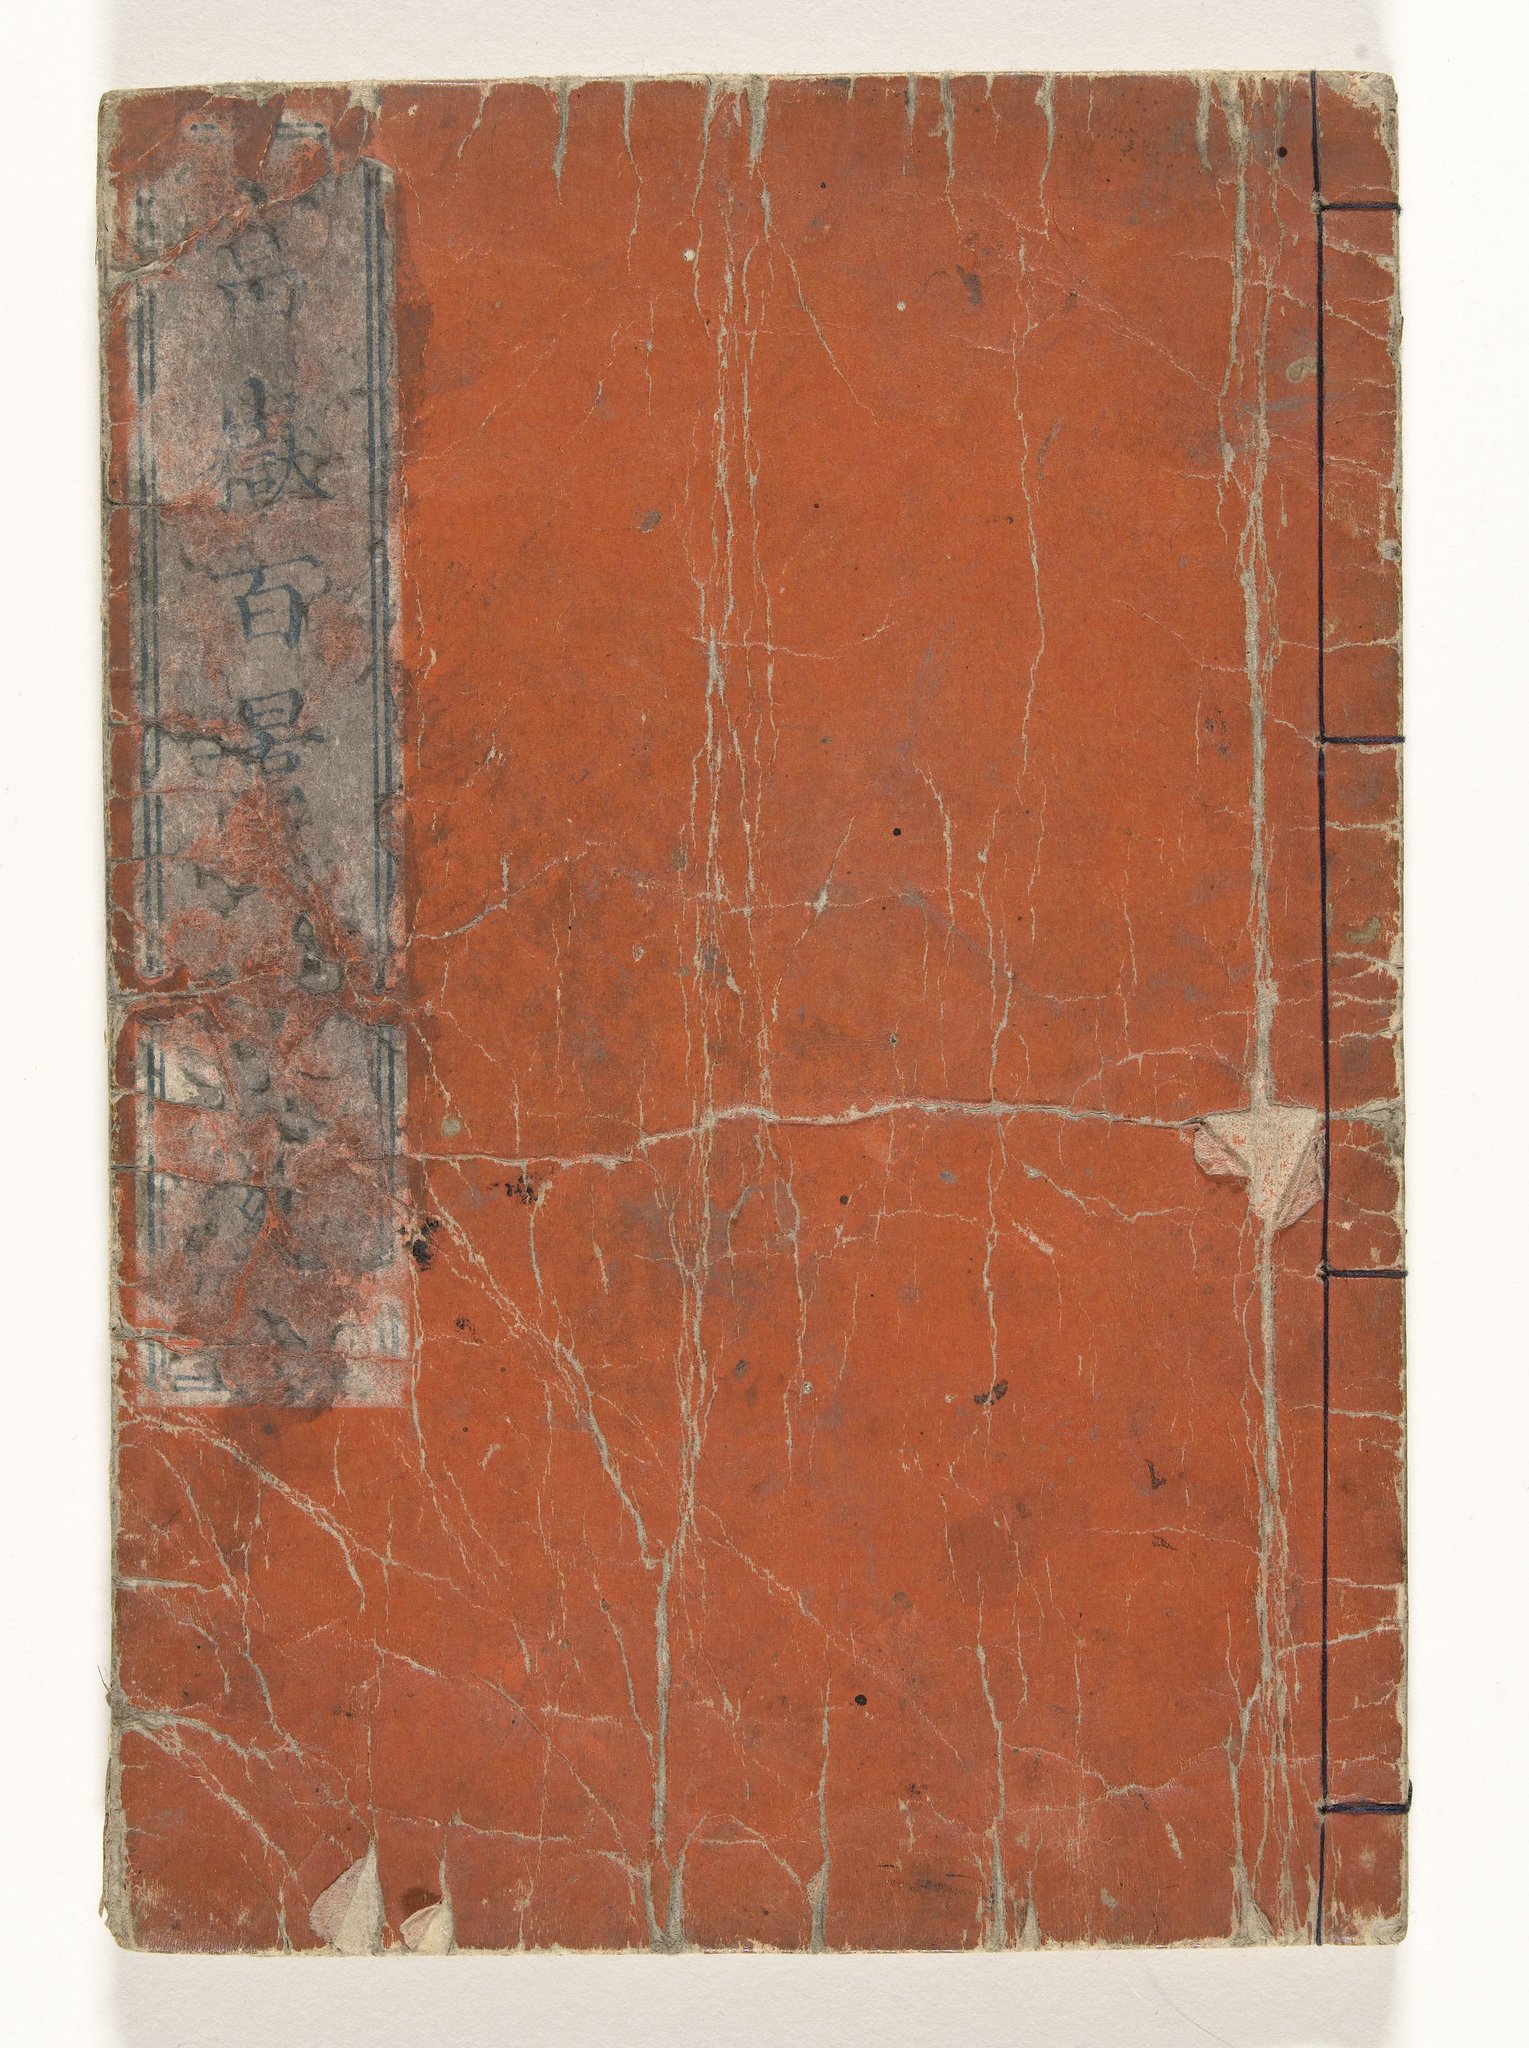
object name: book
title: Honderd gezichten op de berg Fuji - deel drie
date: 1875-1876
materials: paper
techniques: woodcut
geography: edo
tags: fuji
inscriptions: inscription, collector's mark: ‘museum van aziatische kunst rijksmuseum amsterdam-z.’